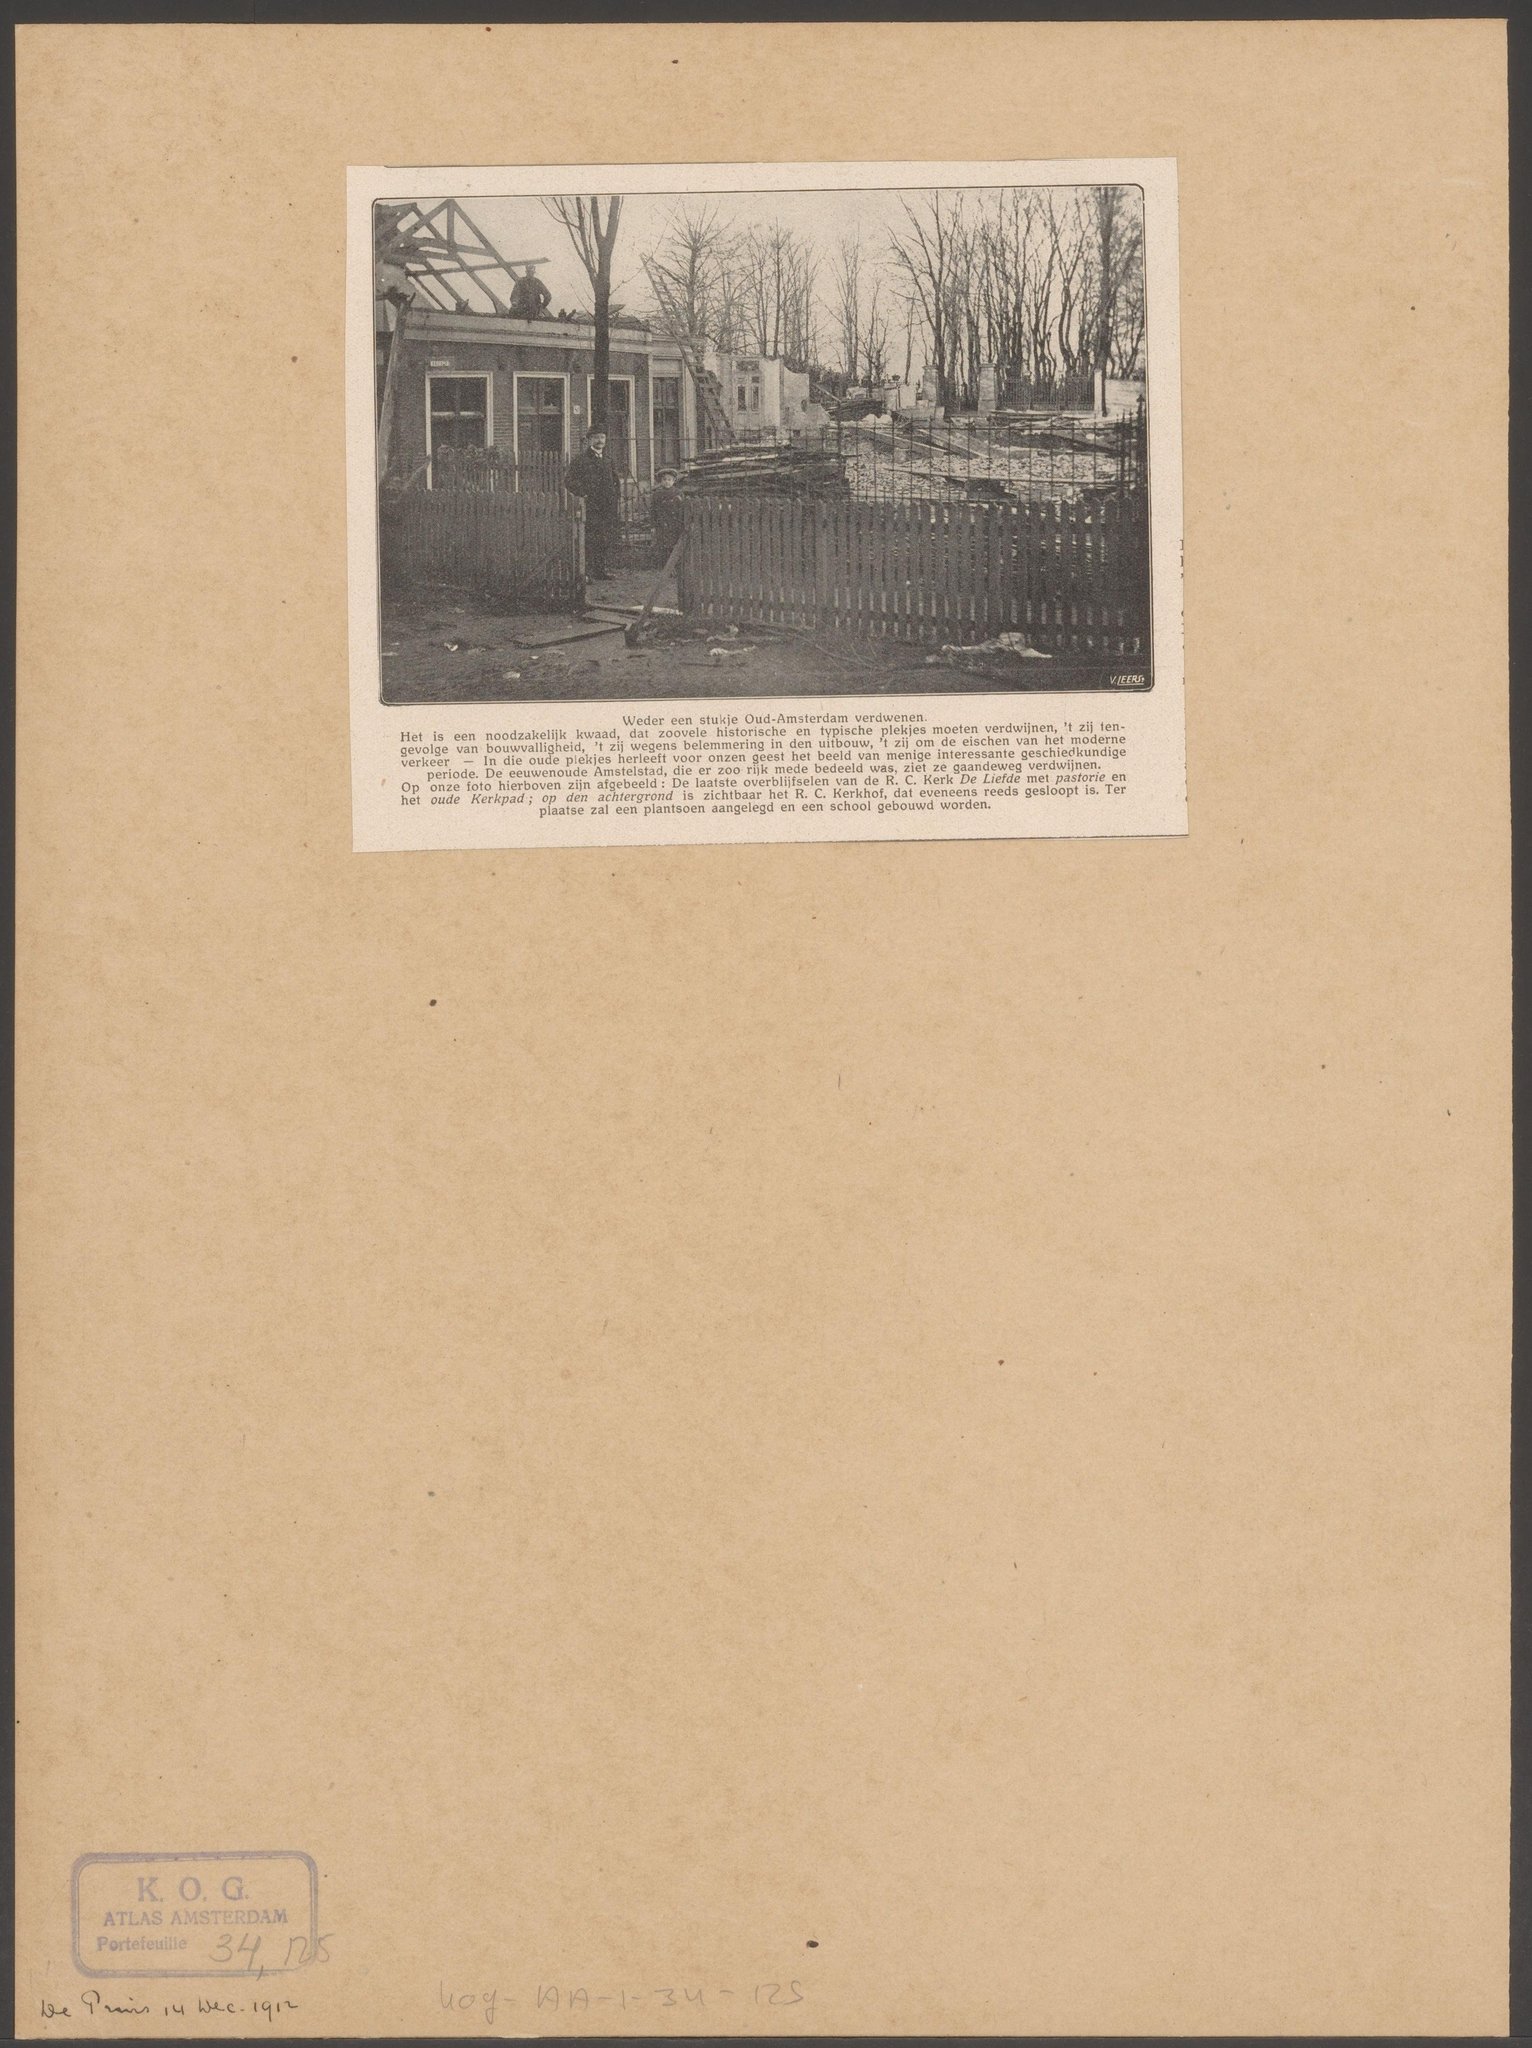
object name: photomechanical print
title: Afbraak van De Liefde te Amsterdam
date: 1912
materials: paper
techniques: letterpress printing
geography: netherlands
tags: fence, wall, paling, demolition of building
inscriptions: collector's mark: Lugt 1641b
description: Onderwerpsrubriek binnen de Atlas Amsterdam: Kerkwezen: R.K. Gemeenten: Begijnhof t/m Petrus en Paulus.